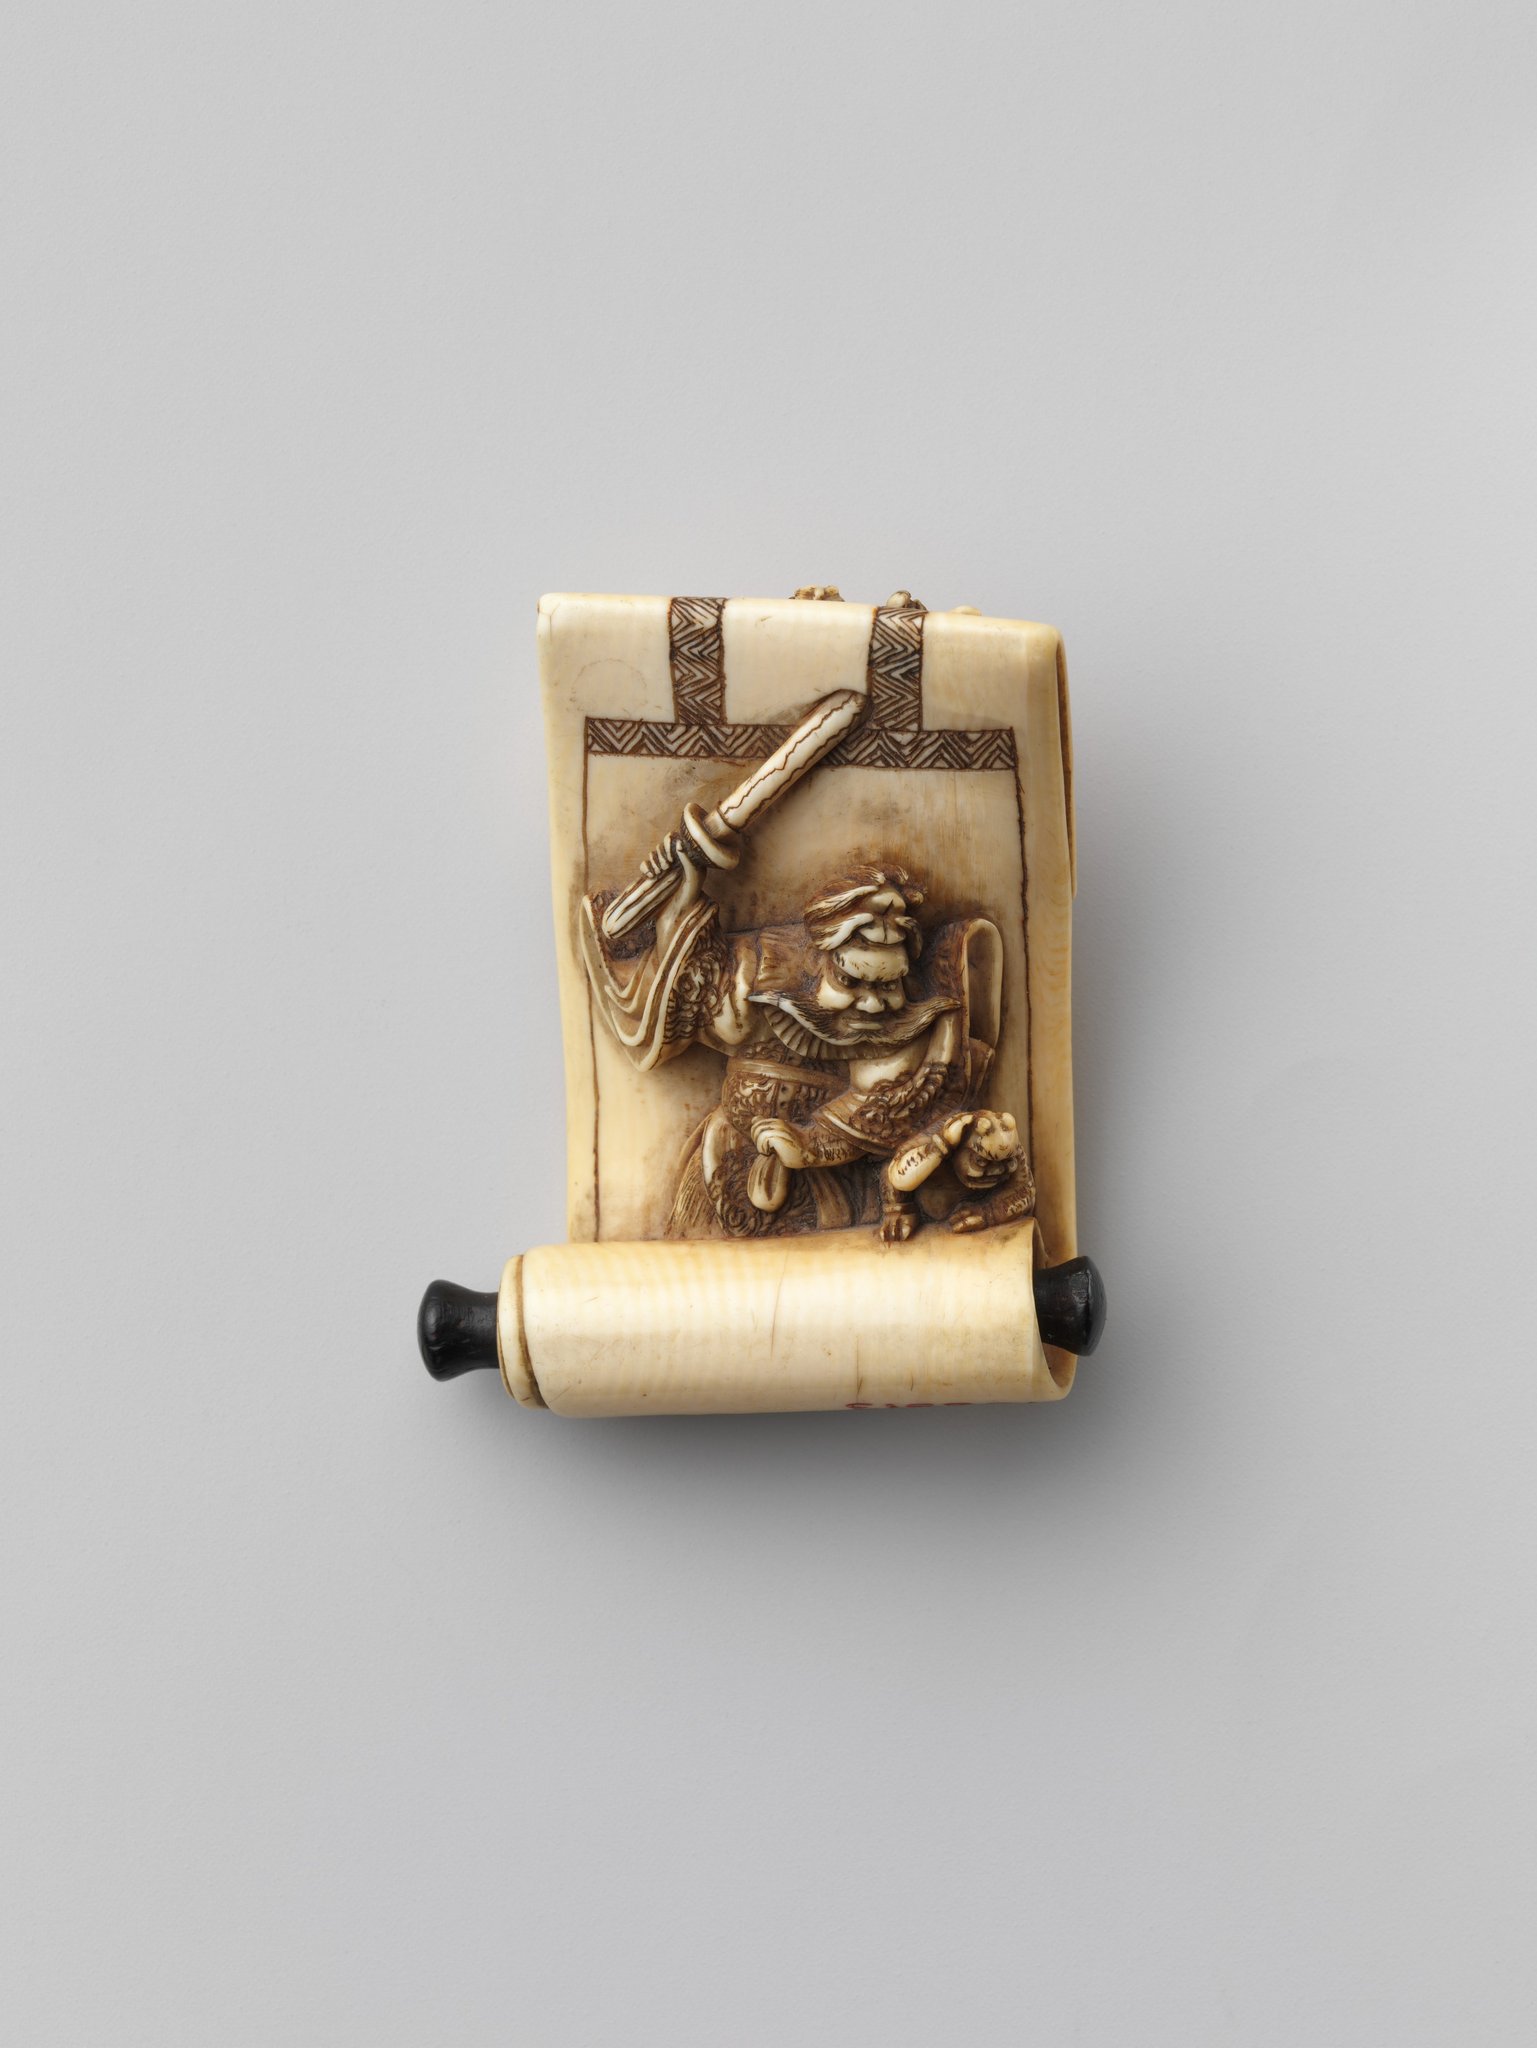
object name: netsuke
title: Shōki Comes to Life from a Hanging Scroll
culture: japanese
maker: shūōsai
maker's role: artist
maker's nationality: japanese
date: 1801-1850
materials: ivory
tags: scrolls,men,demons